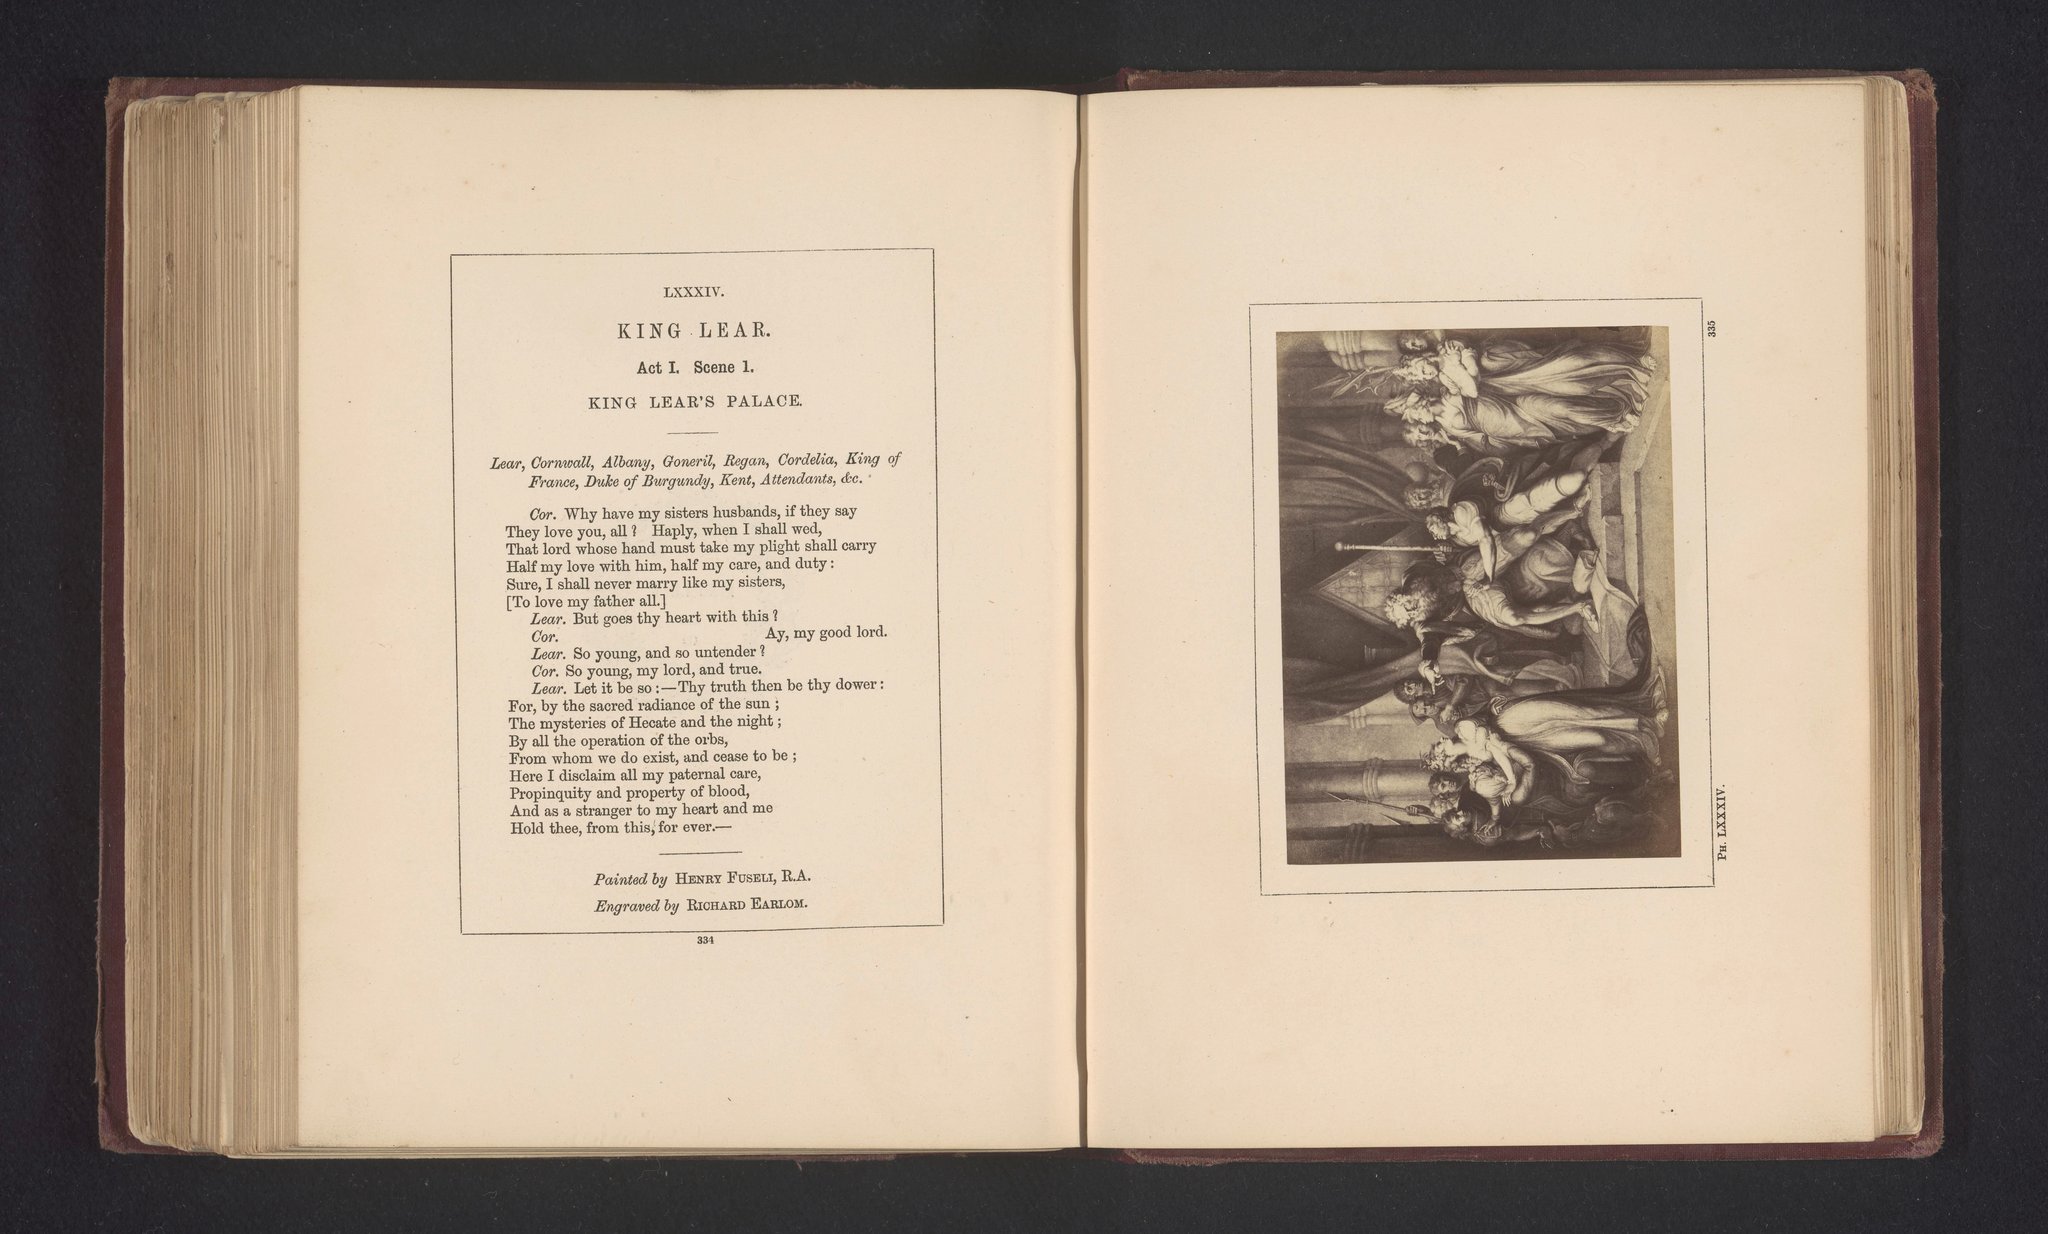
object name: photograph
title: Fotoreproductie van een prent naar een schilderij door Johann Heinrich Füssli, voorstellend een scene uit Koning Lear door William Shakespeare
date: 1854-1867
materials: photographic support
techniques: albumen print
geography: london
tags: king lear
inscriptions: number: ‘Ph. LXXXIV. 335’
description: Te zien is akte I, scene 1 met een gezelschap voor koning Lear.